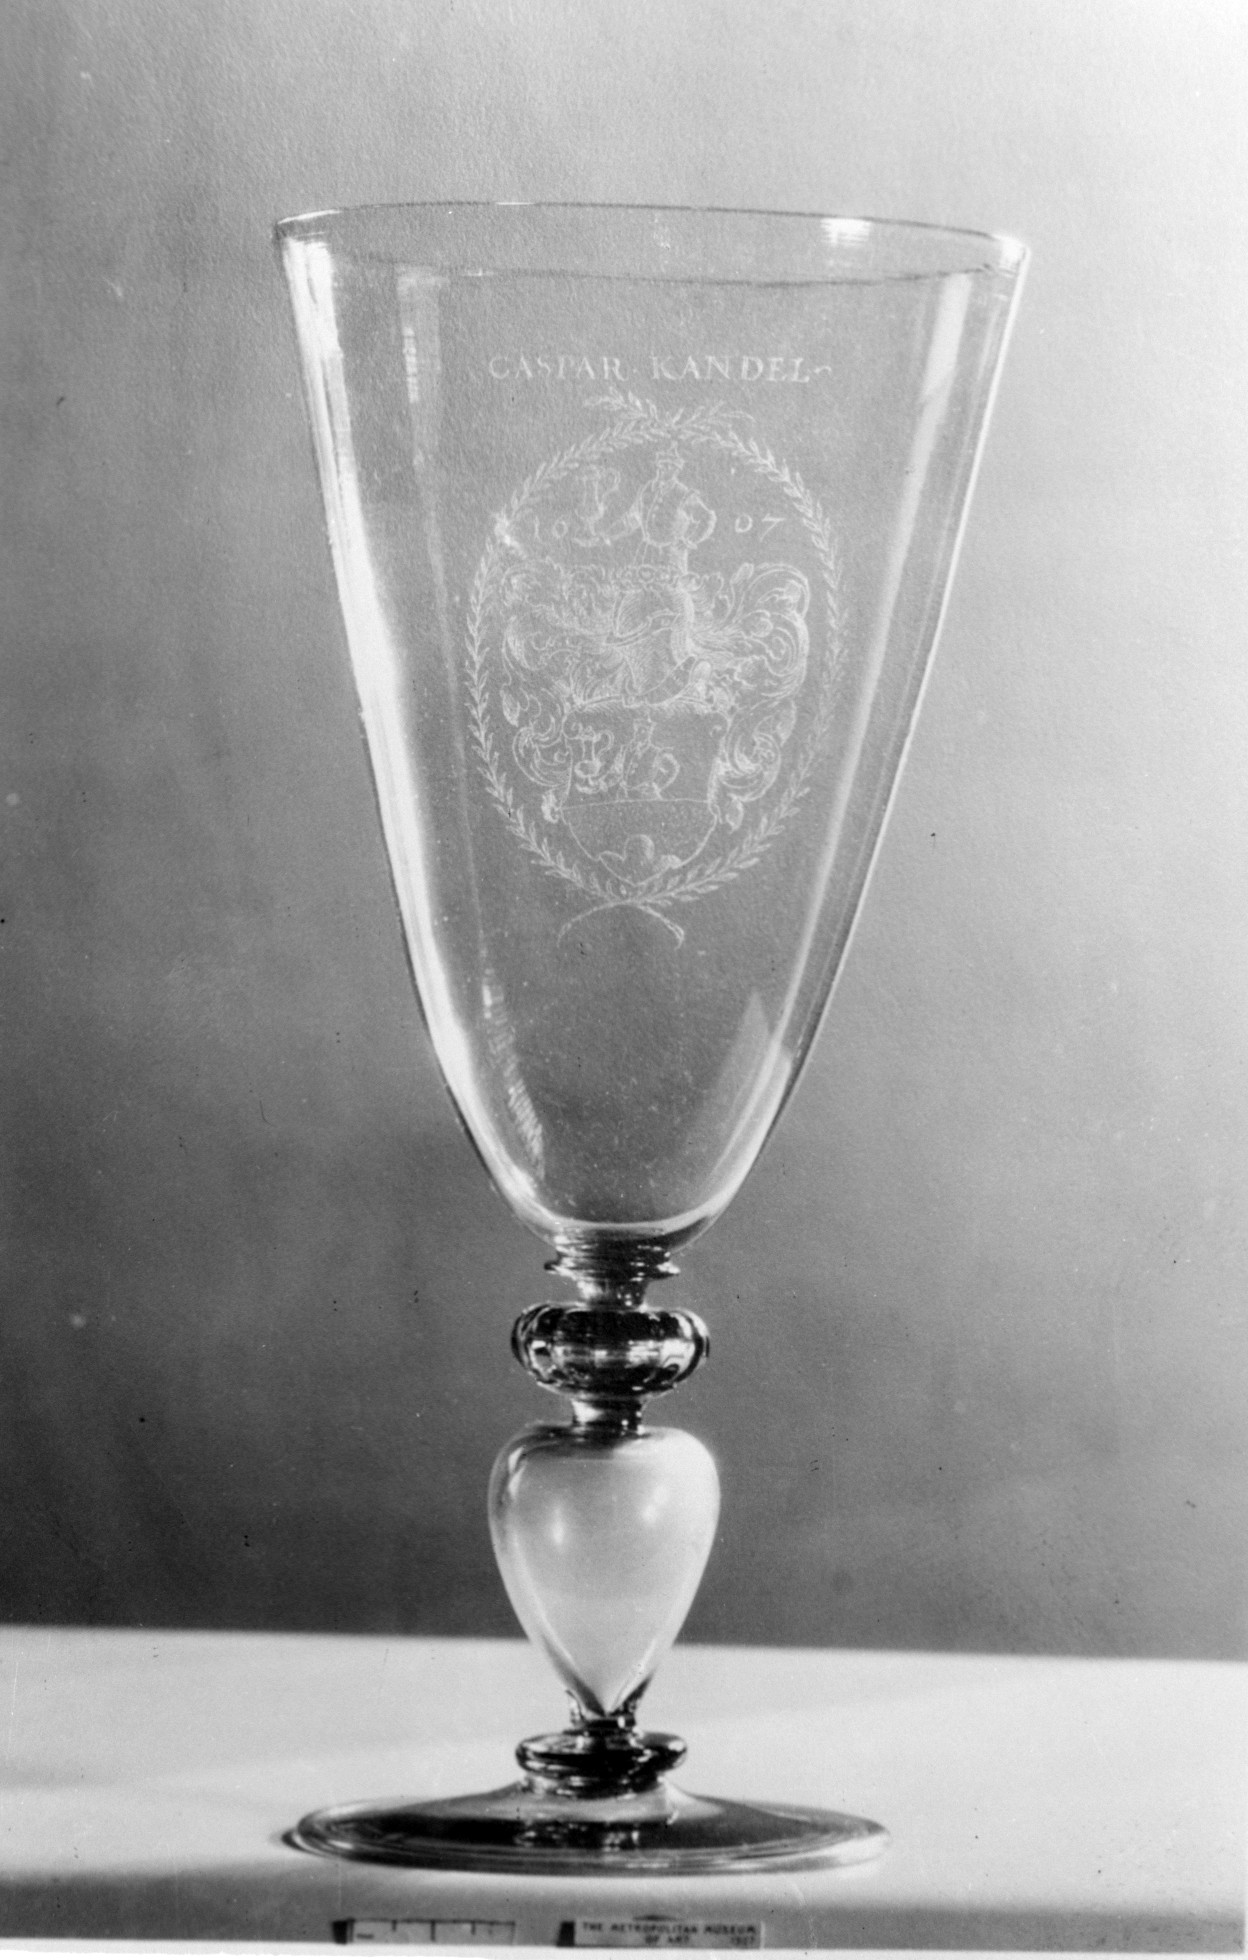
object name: standing cup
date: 1607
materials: glass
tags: men,coat of arms